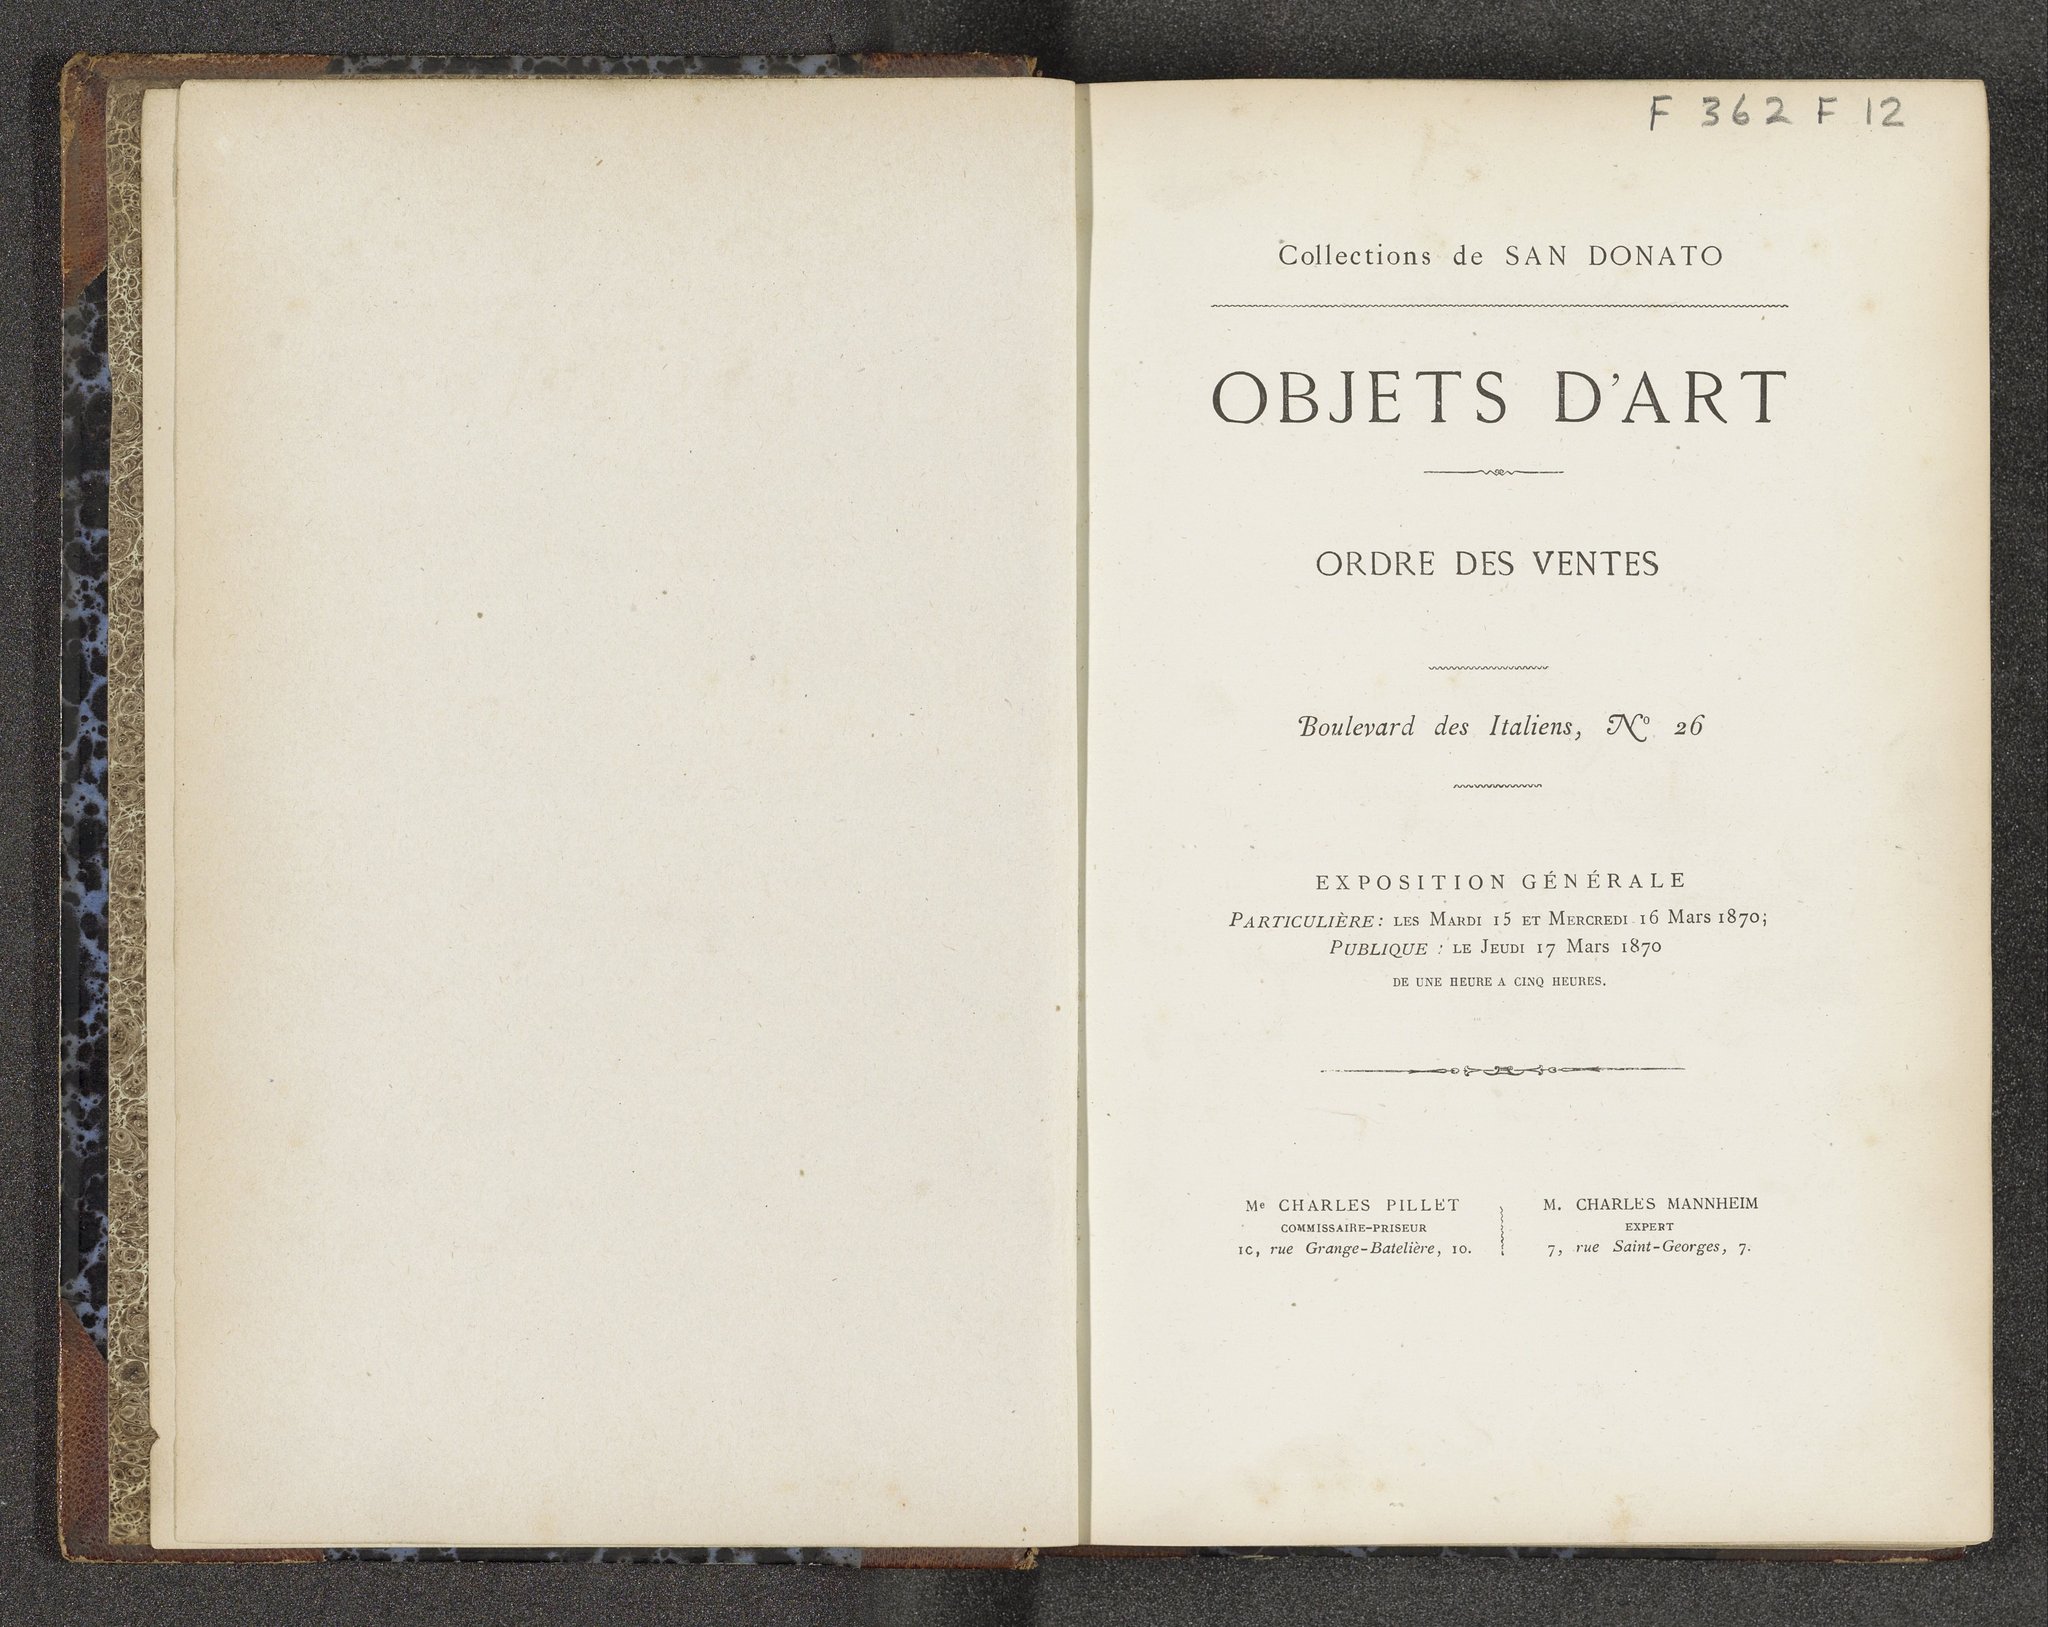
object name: book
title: Objets d'art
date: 1870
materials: leather, paper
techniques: marbled paper, woodburytype